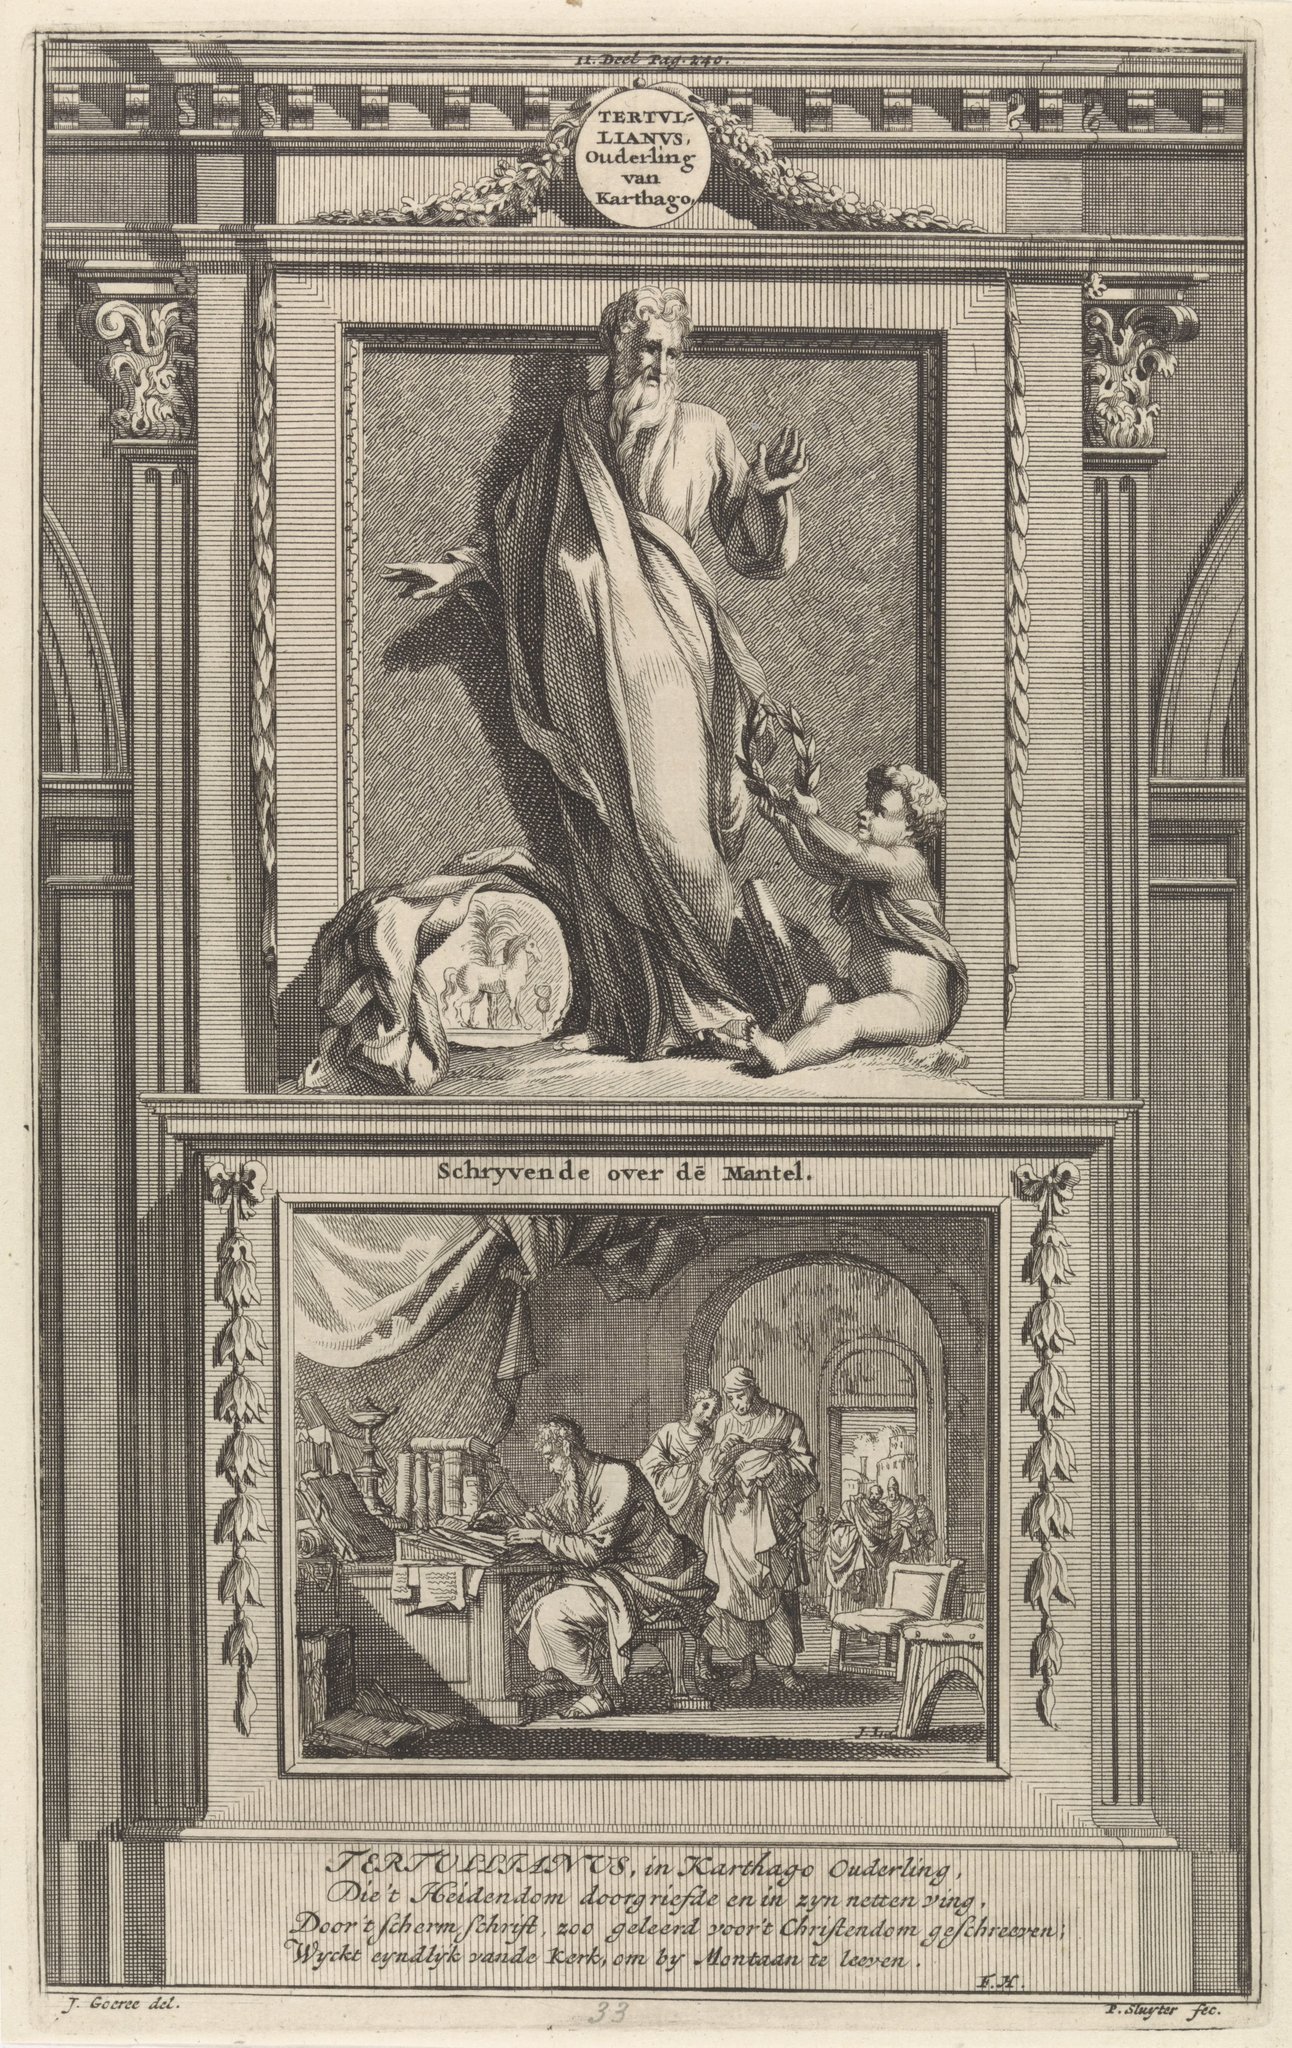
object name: print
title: Kerkvader Tertullianus van Carthago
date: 1698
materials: paper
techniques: engraving, etching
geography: amsterdam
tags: male saints (tertullian of carthage), writer, poet, author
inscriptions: number: ‘33’, collector's mark: Lugt 2228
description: De kerkvader Tertullianus van Carthago kijkt naar een engel die hem een lauwerkrans aanbiedt. Tertullianus staat op een sokkel. Op de voorzijde een scène waarin hij een van zijn geschriften schrijft. Prent middenboven gemerkt: II. Deel Pag: 240.